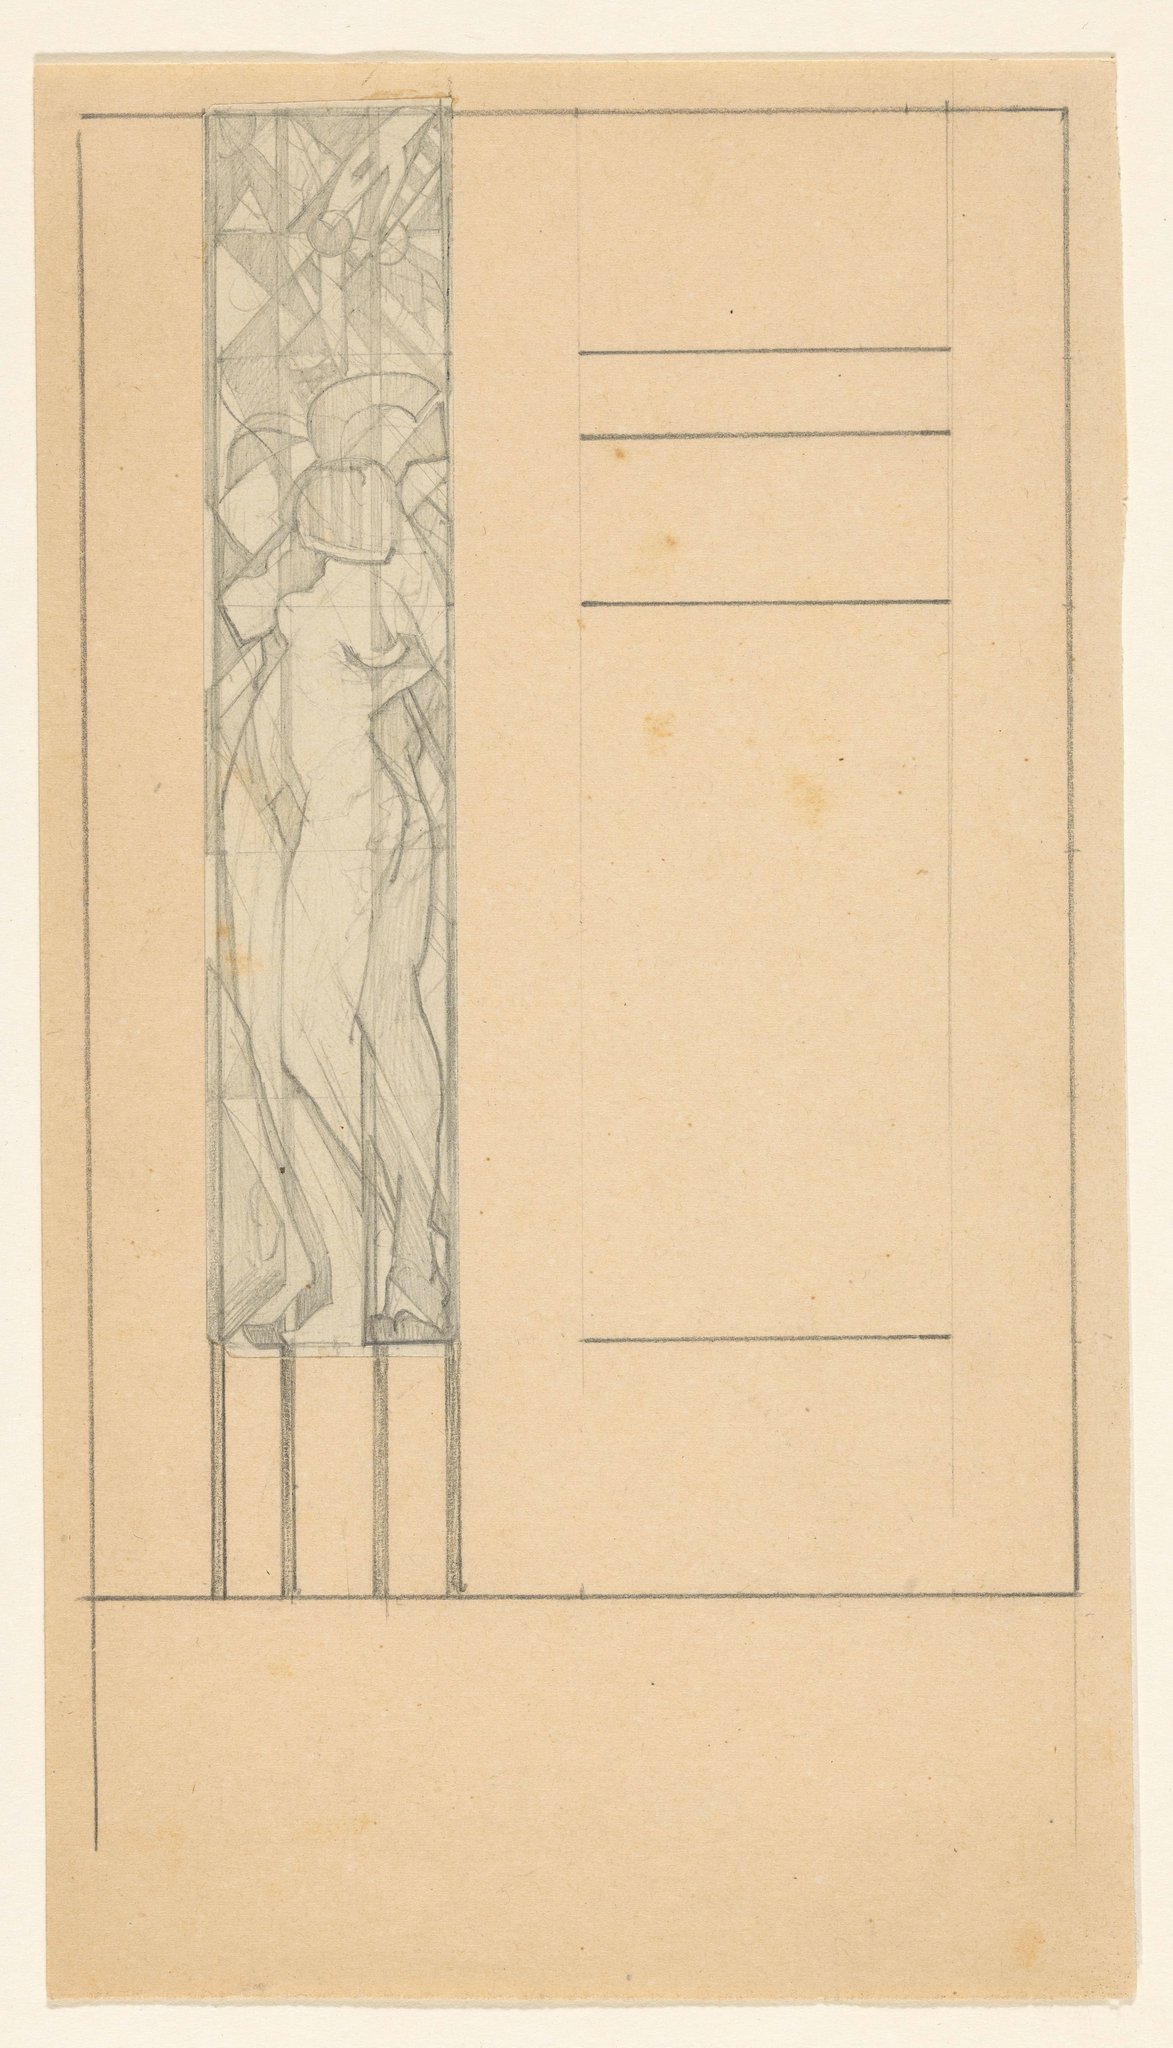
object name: drawing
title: Bandontwerp voor: Nescio, Dichtertje, de uitvreter en titaantjes, 1918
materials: paper, pencil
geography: haarlem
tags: book-cover, binding, (scenes from) specific works of literature (with author, title)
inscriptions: collector's mark: Lugt 2228, collector's mark: Lugt 2760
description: Bandontwerp voor: Nescio. Dichtertje, de uitvreter en titaantjes. Haarlem: Johannes Henricus de Bois, 1918.